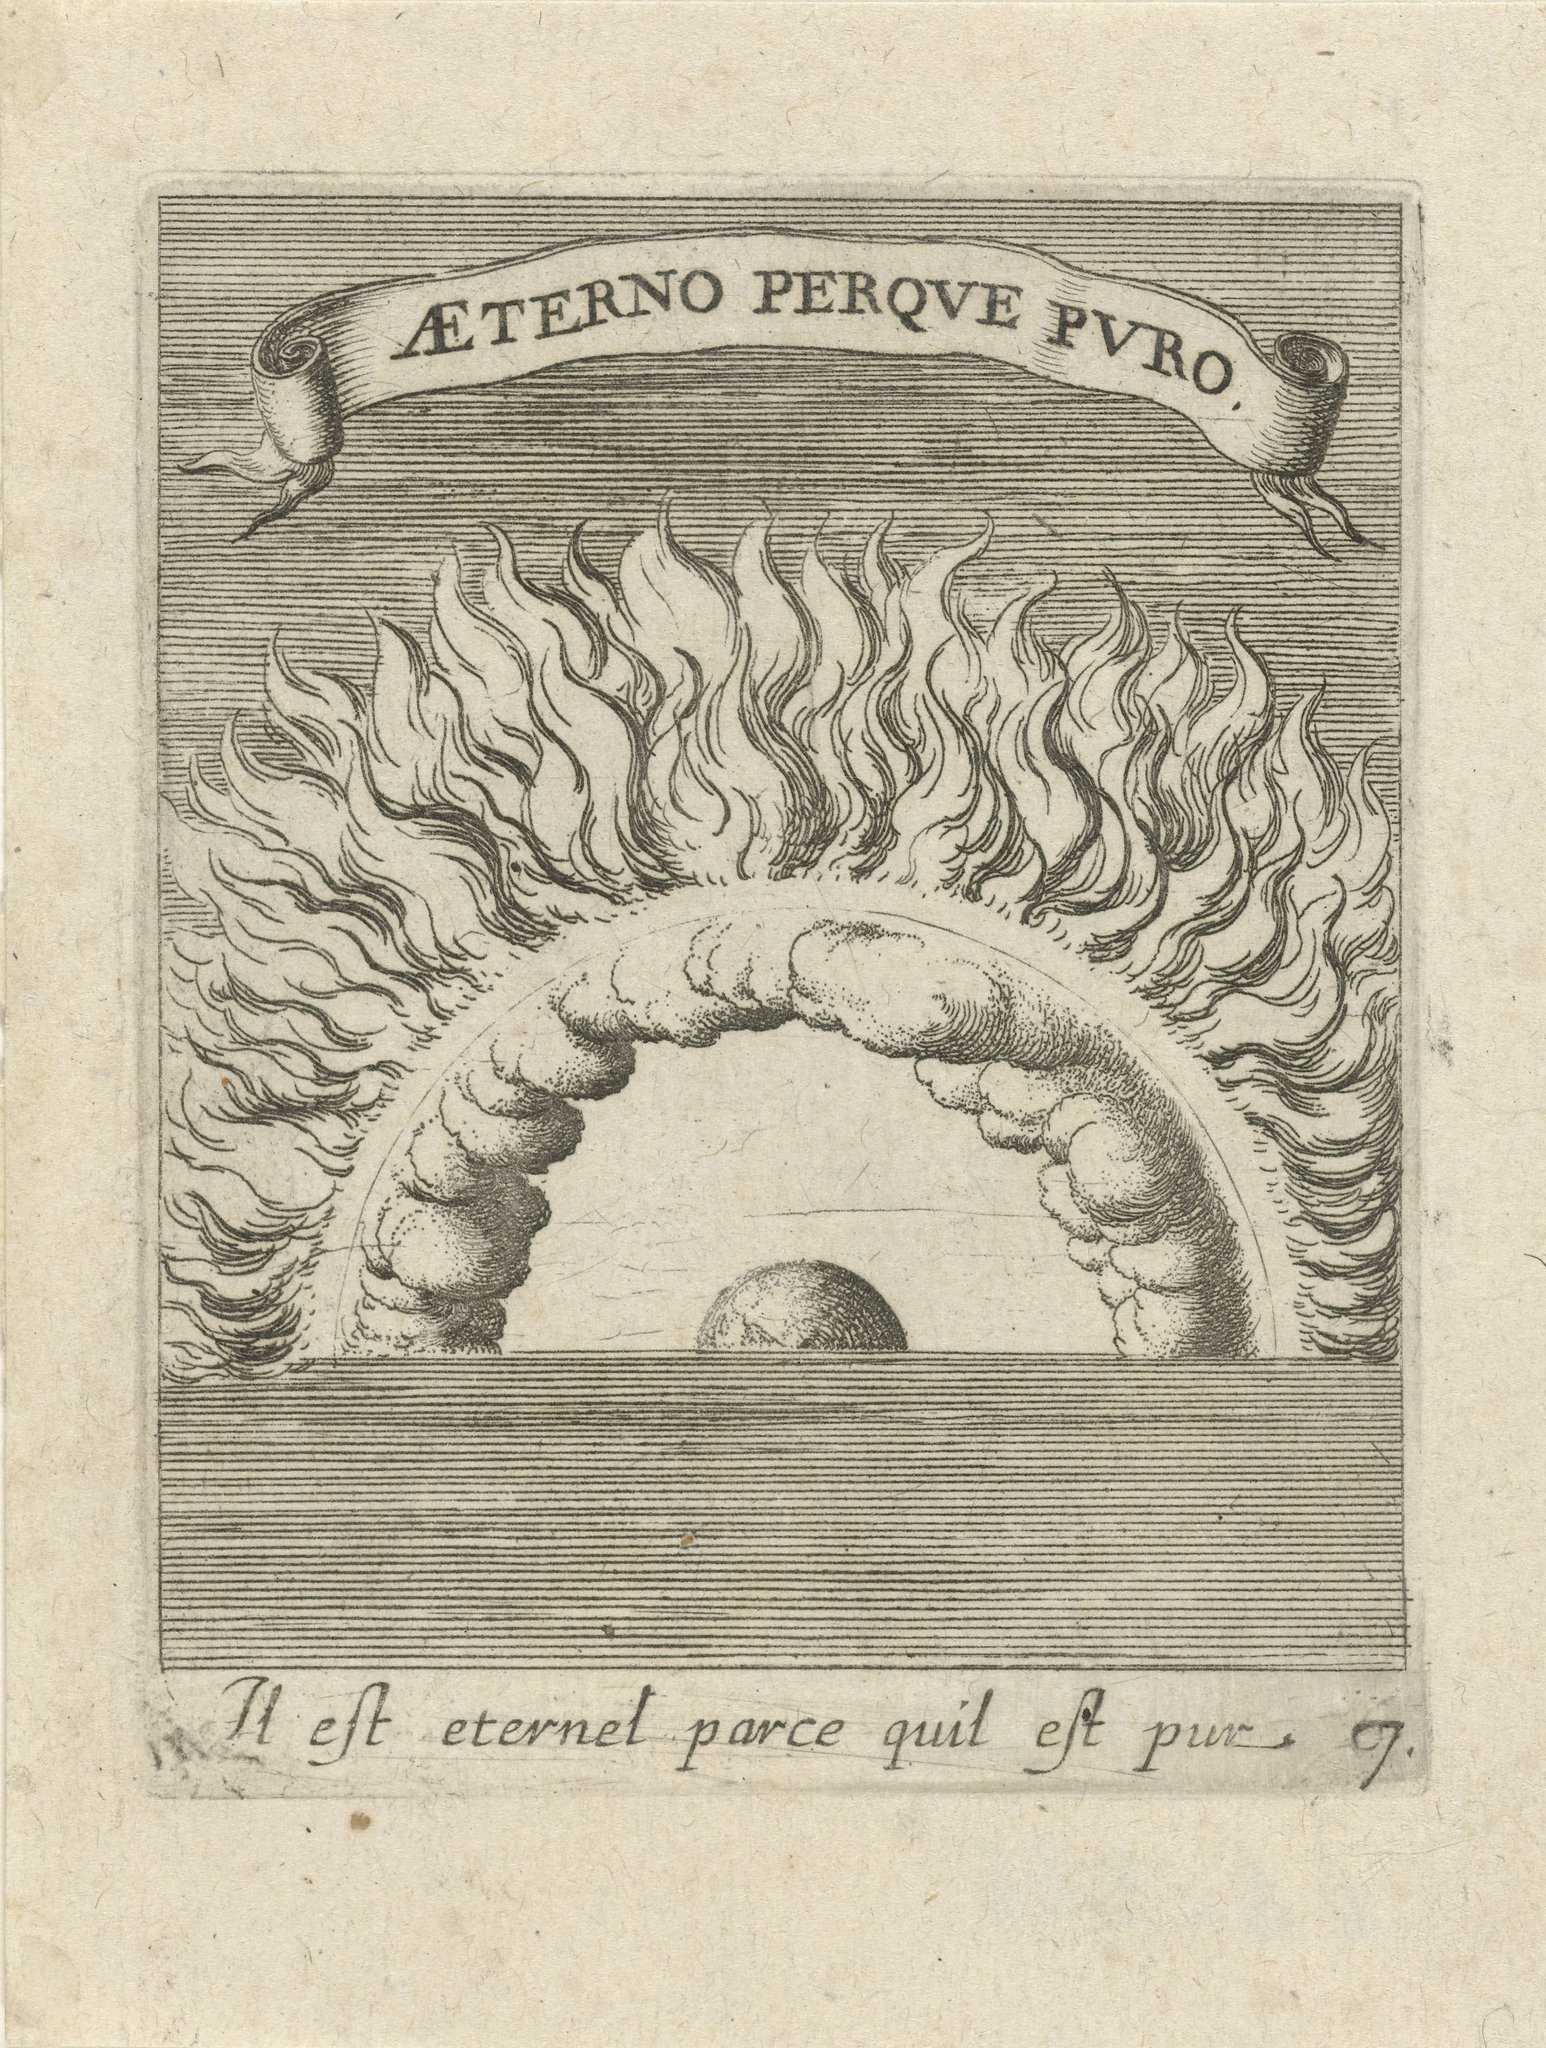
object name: print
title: Vlammende hemel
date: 1672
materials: paper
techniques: etching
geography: paris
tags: qualities of love: first series (+ emblematical representation of concept)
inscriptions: collector's mark: Lugt 2166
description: Een gezicht op de aardbol met daarboven wolken en een boog van vlammen. Op een banderol een devies in Latijn en een onderschrift in Frans, beide over de liefde.